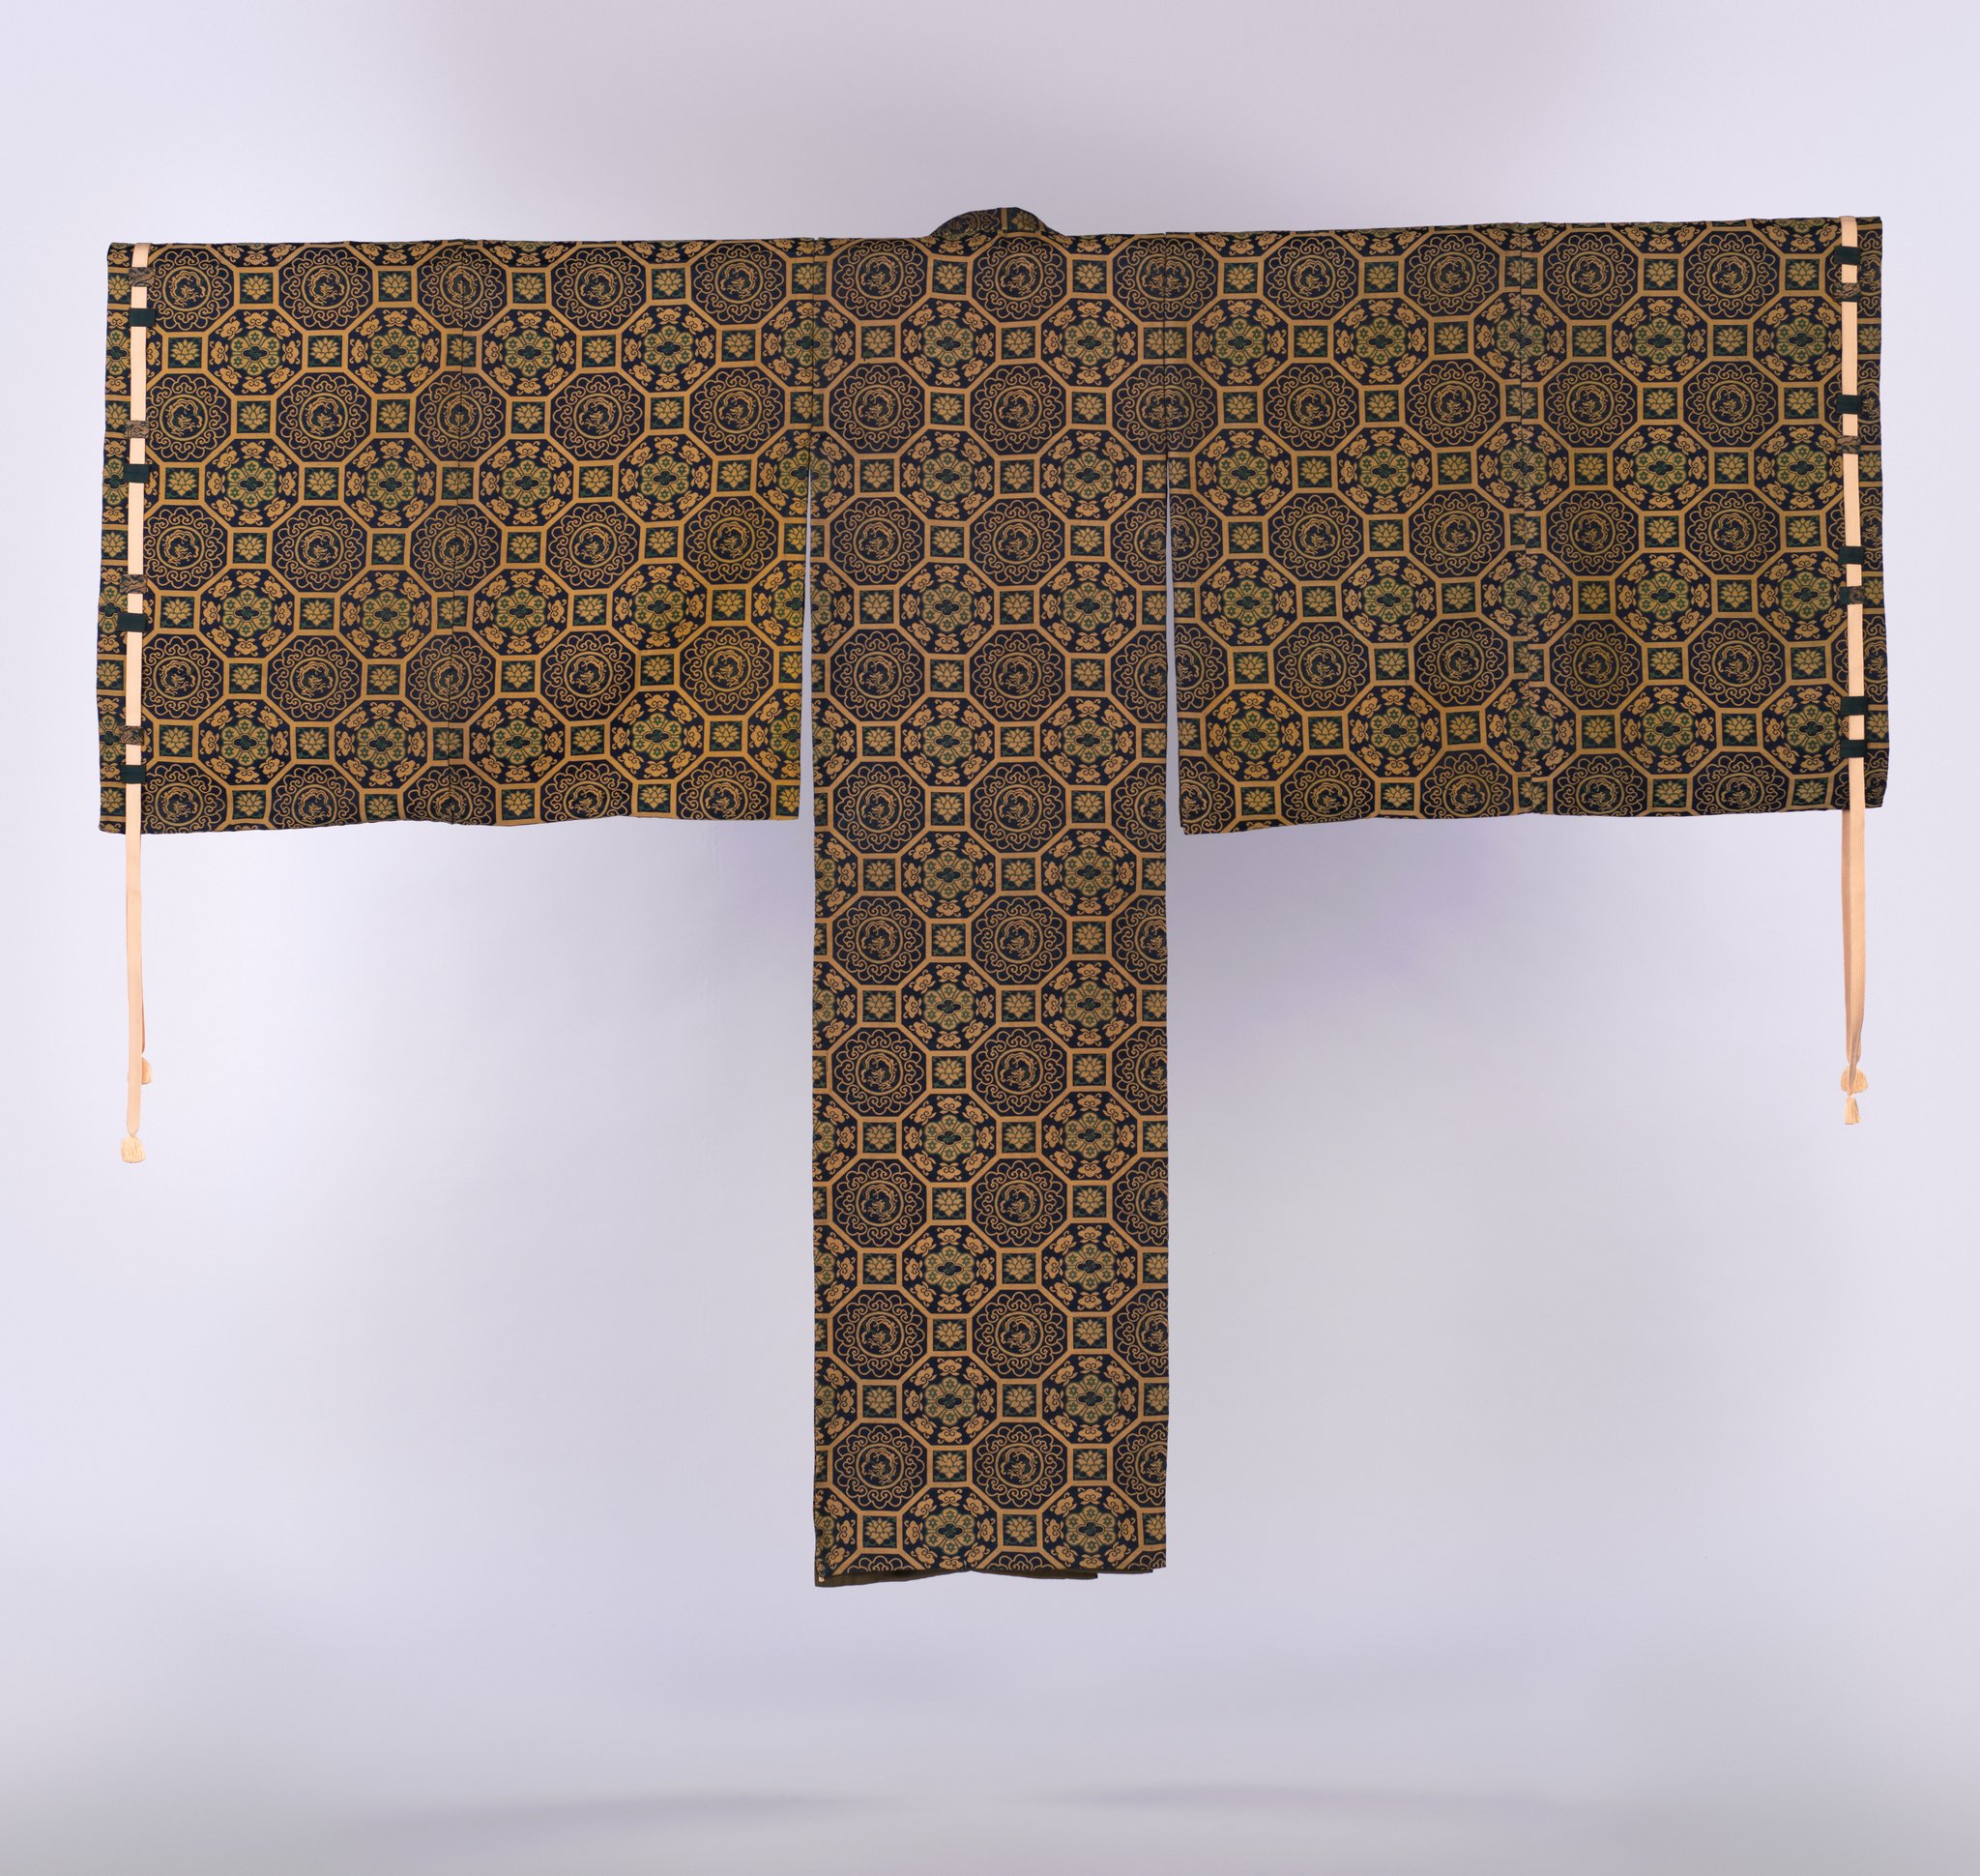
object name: noh costume kariginu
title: Noh Costume (Kariginu)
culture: japanese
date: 1801-1850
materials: silk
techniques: patterning, weave